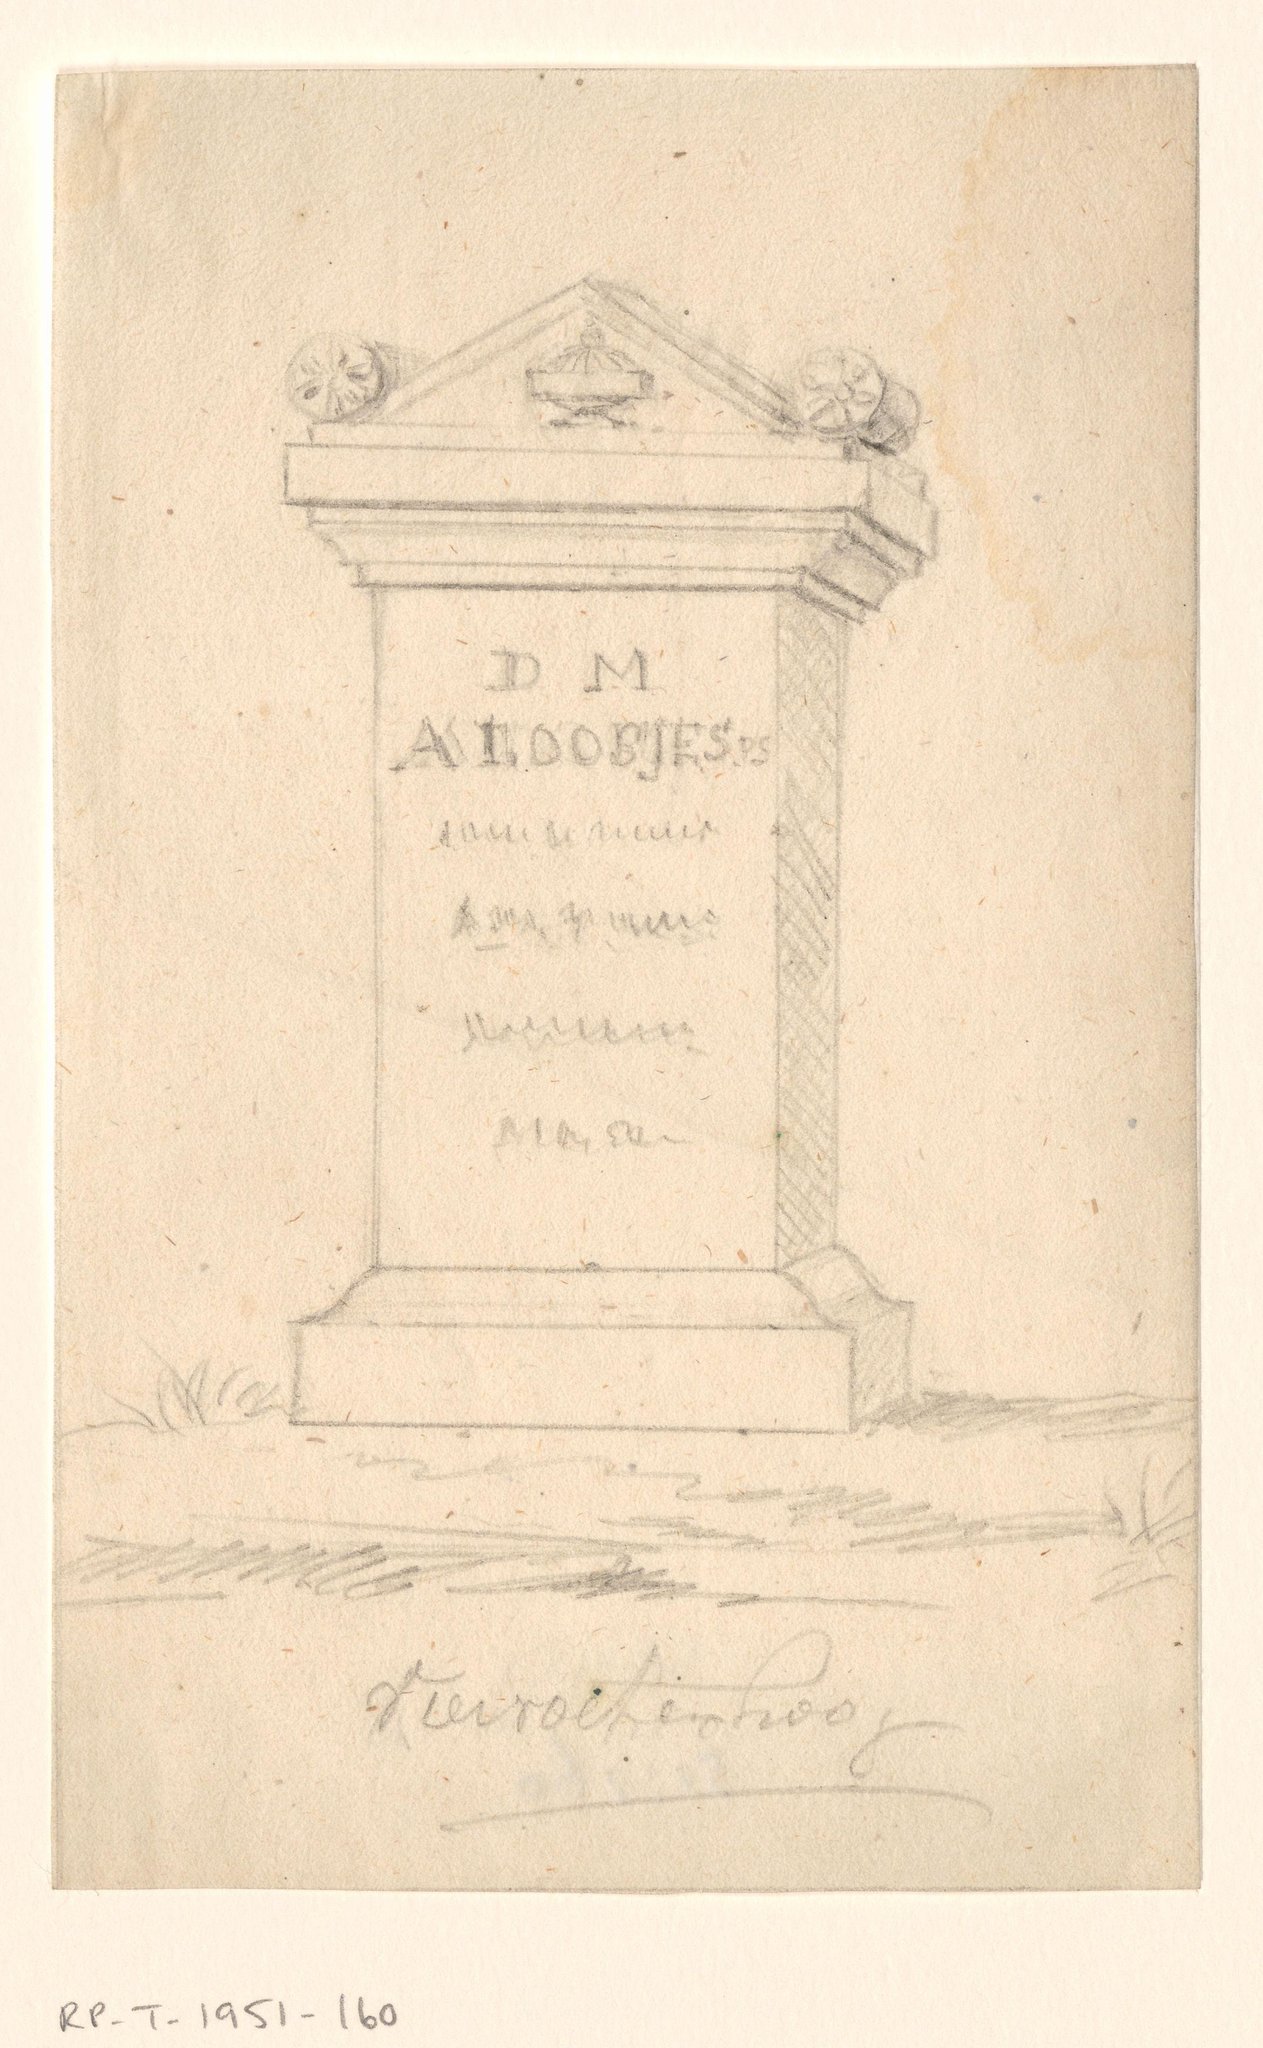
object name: drawing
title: Grafsteen voor Adriaan Pietersz. Loosjes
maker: hermanus van brussel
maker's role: draughtsman, print maker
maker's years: 1763-1815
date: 1800-1820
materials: paper, pencil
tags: haarlem, publisher, bookseller, adriaan pietersz. loosjes, historical persons, grave, tomb and other grave-forms and grave-markers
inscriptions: inscription: ‘Viervoetenhoog’, collector's mark: Lugt 2228